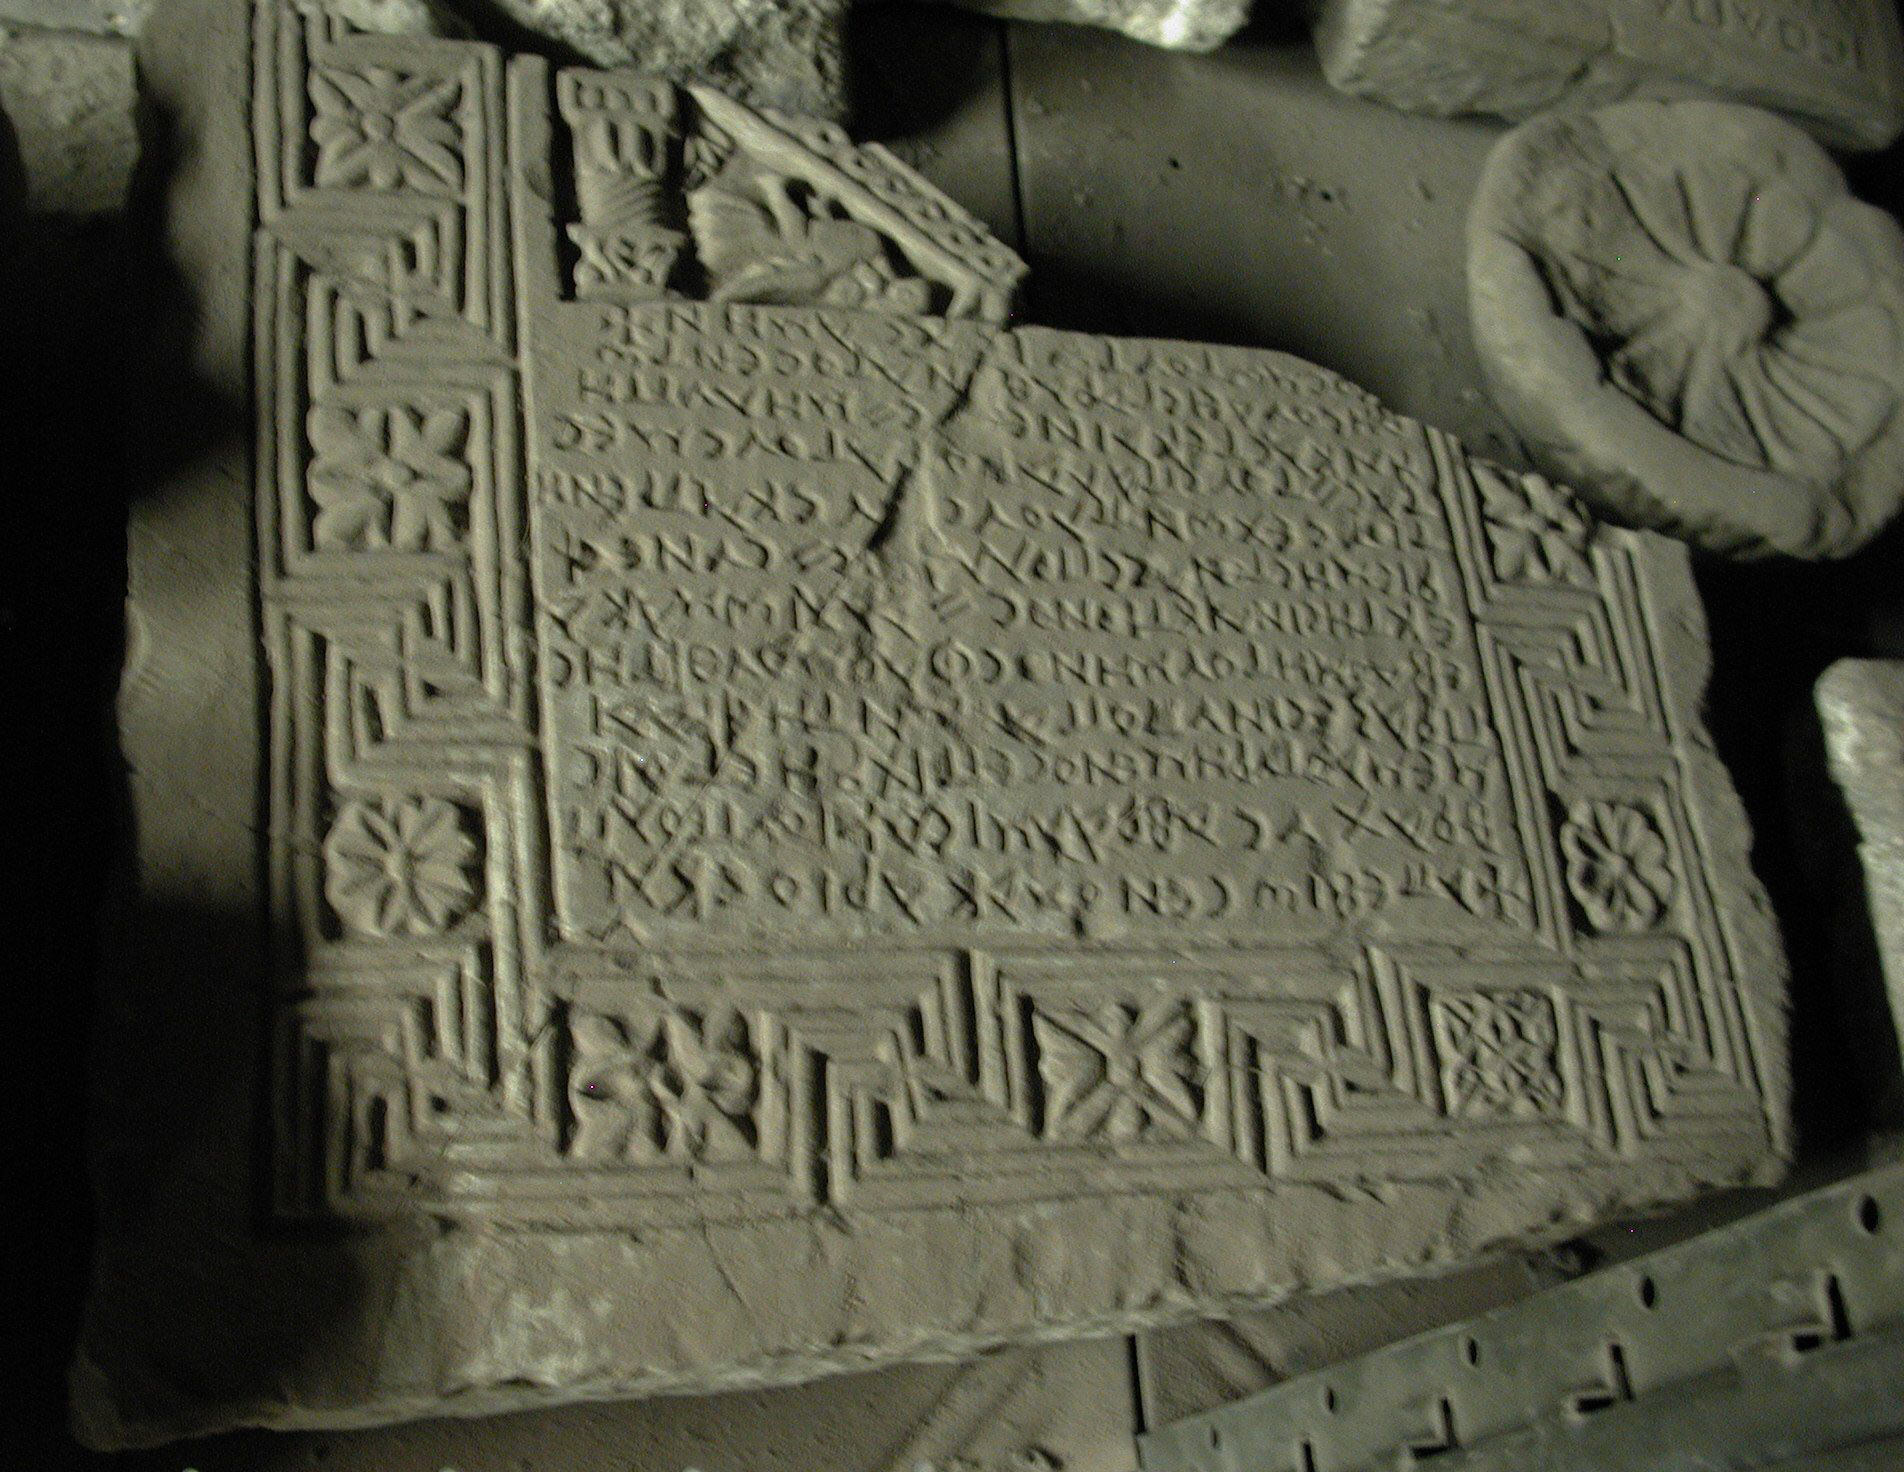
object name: stele fragment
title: Fragment of an Inscribed Stele Enclosed in a Frame with Swastikas and Rosettes; Part of a Gable with Bird and a Pilaster.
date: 601-800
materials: limestone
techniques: carving, incising, relief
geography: egypt